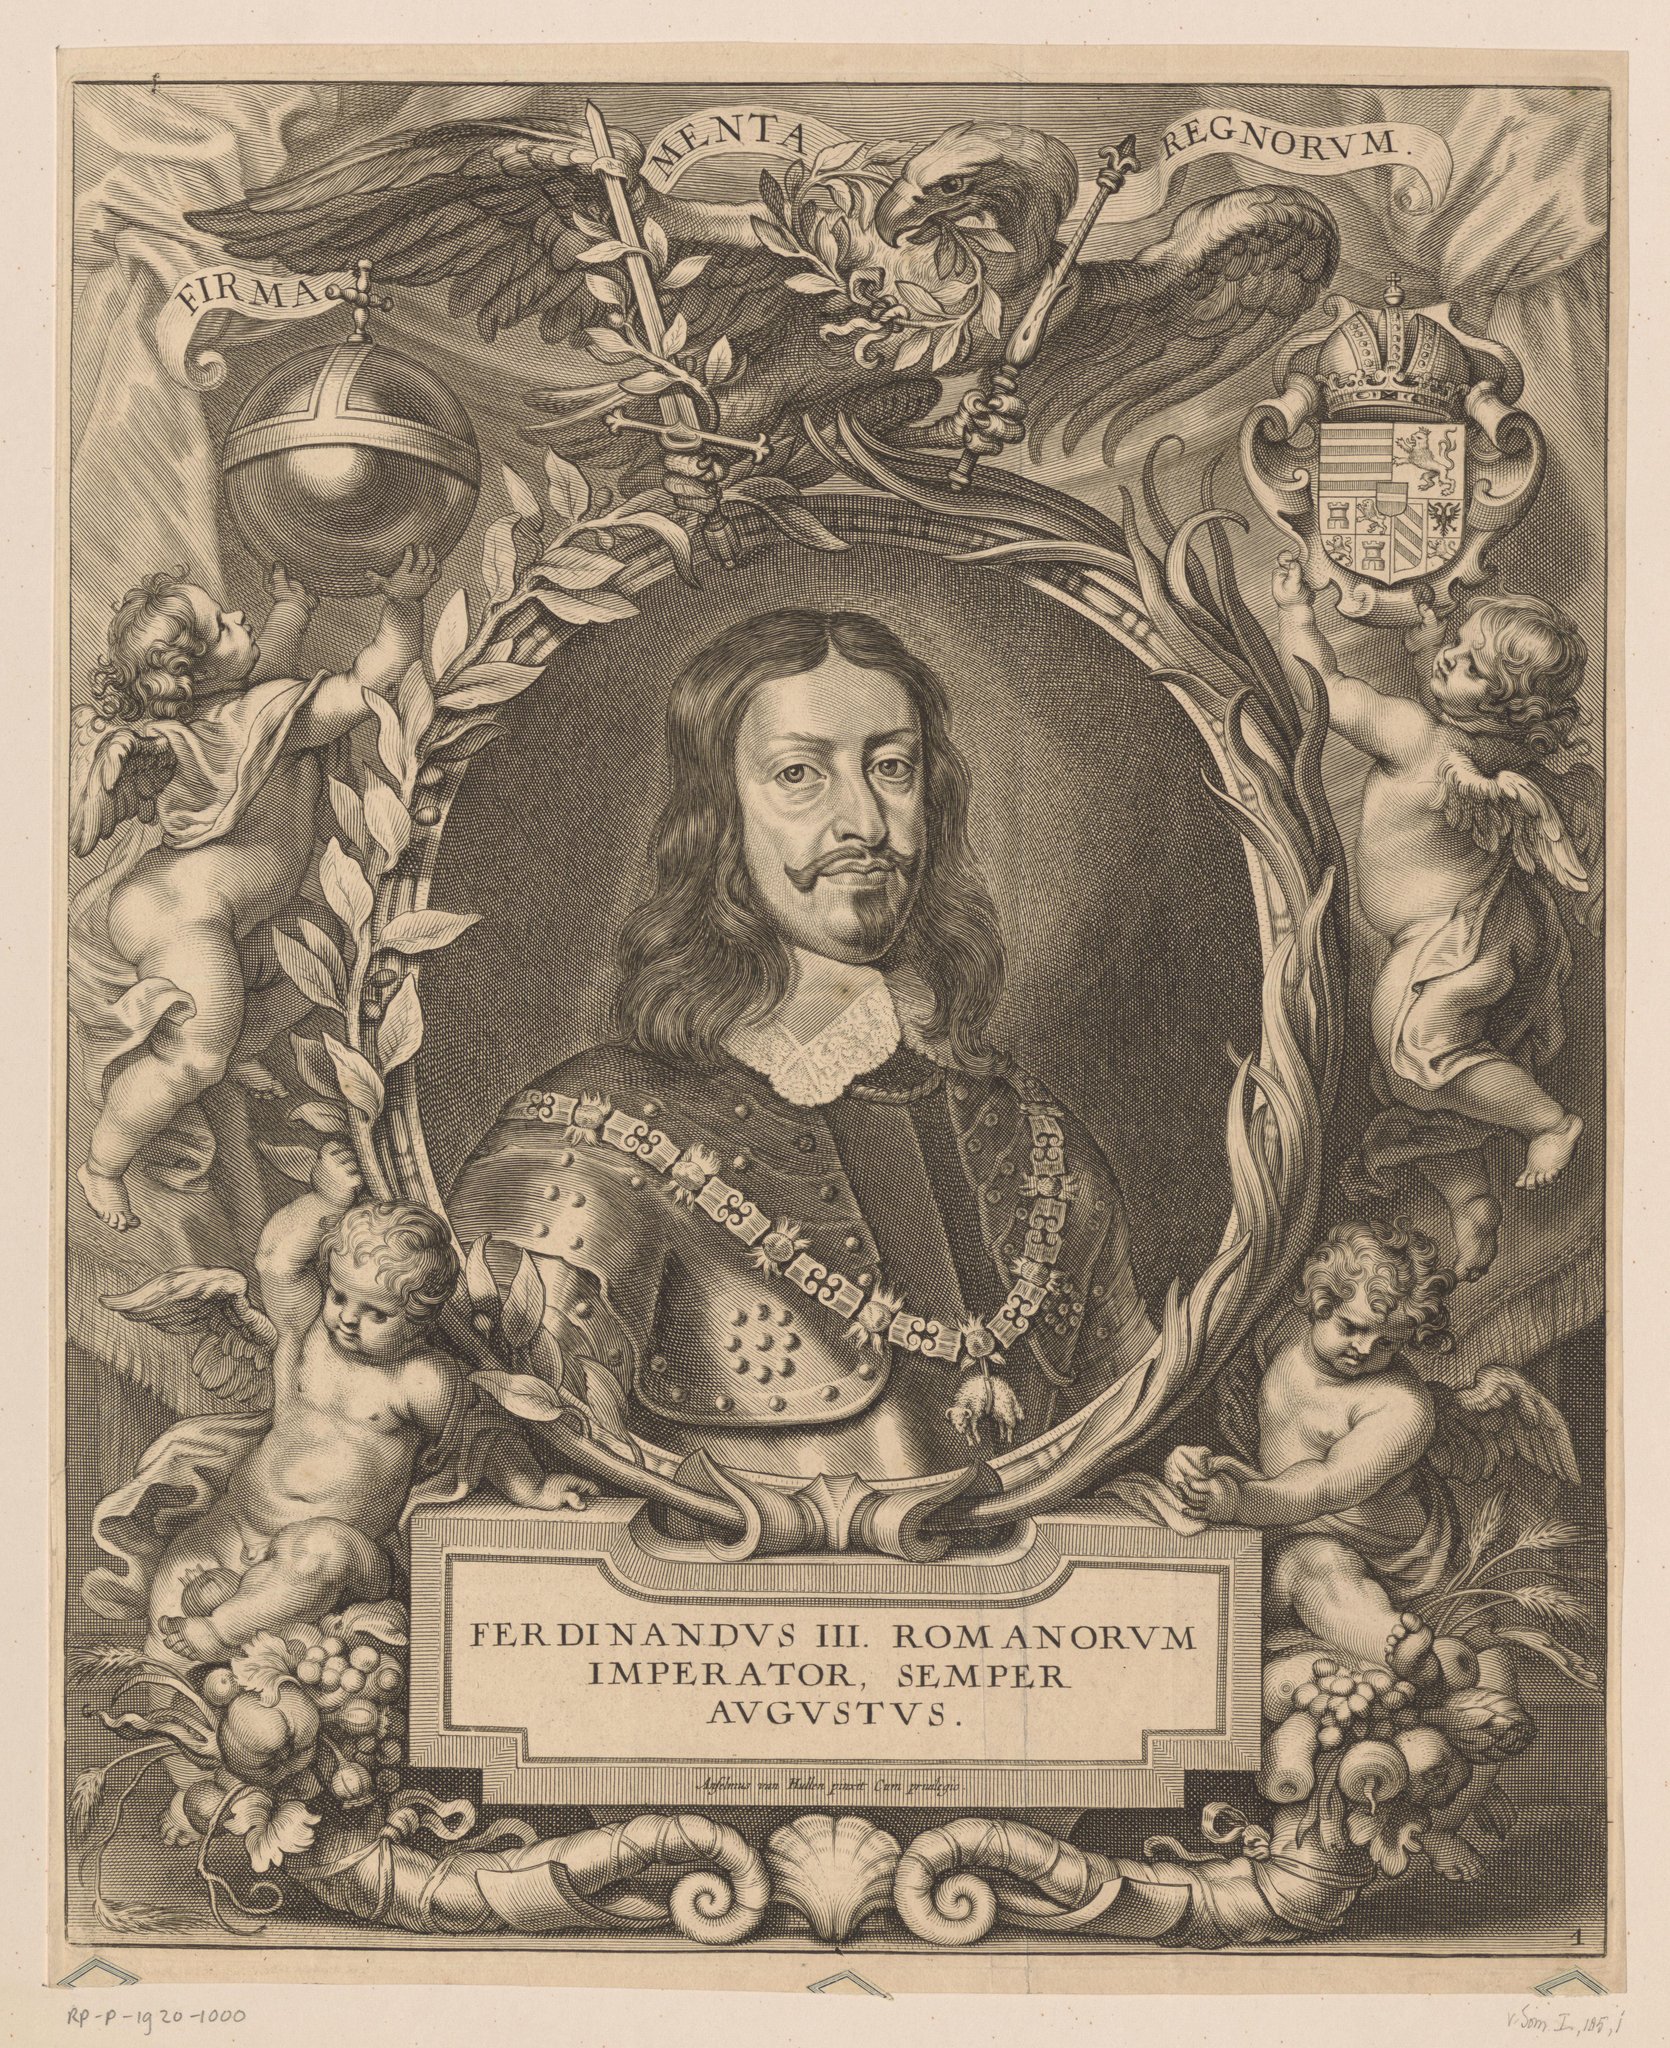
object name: print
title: Hommes les illustres qui ont vécu dans le XVIIe siecle (...)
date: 1713-1717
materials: paper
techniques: engraving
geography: northern netherlands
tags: ferdinand iii (duits keizer), coat of arms (symbol of sovereignty), orb (symbol of sovereignty; sphere with cross on top), armour, historical persons, knighthood order of the golden fleece, cupids: 'amores', 'amoretti', 'putti'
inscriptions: collector's mark: Lugt 2228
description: De prent is genummerd gebruikt in een druk van 'Pacificatores Orbis Christiani, sive icones principum (...)'. Deze editie is ca. 1713 uitgegeven maar heeft het jaartal 1697, zie Van Someren. De prent is ook genummerd gebruikt voor de serie 'Hommes les illustres qui ont vécu dans le XVIIe siecle (...)', 1717.